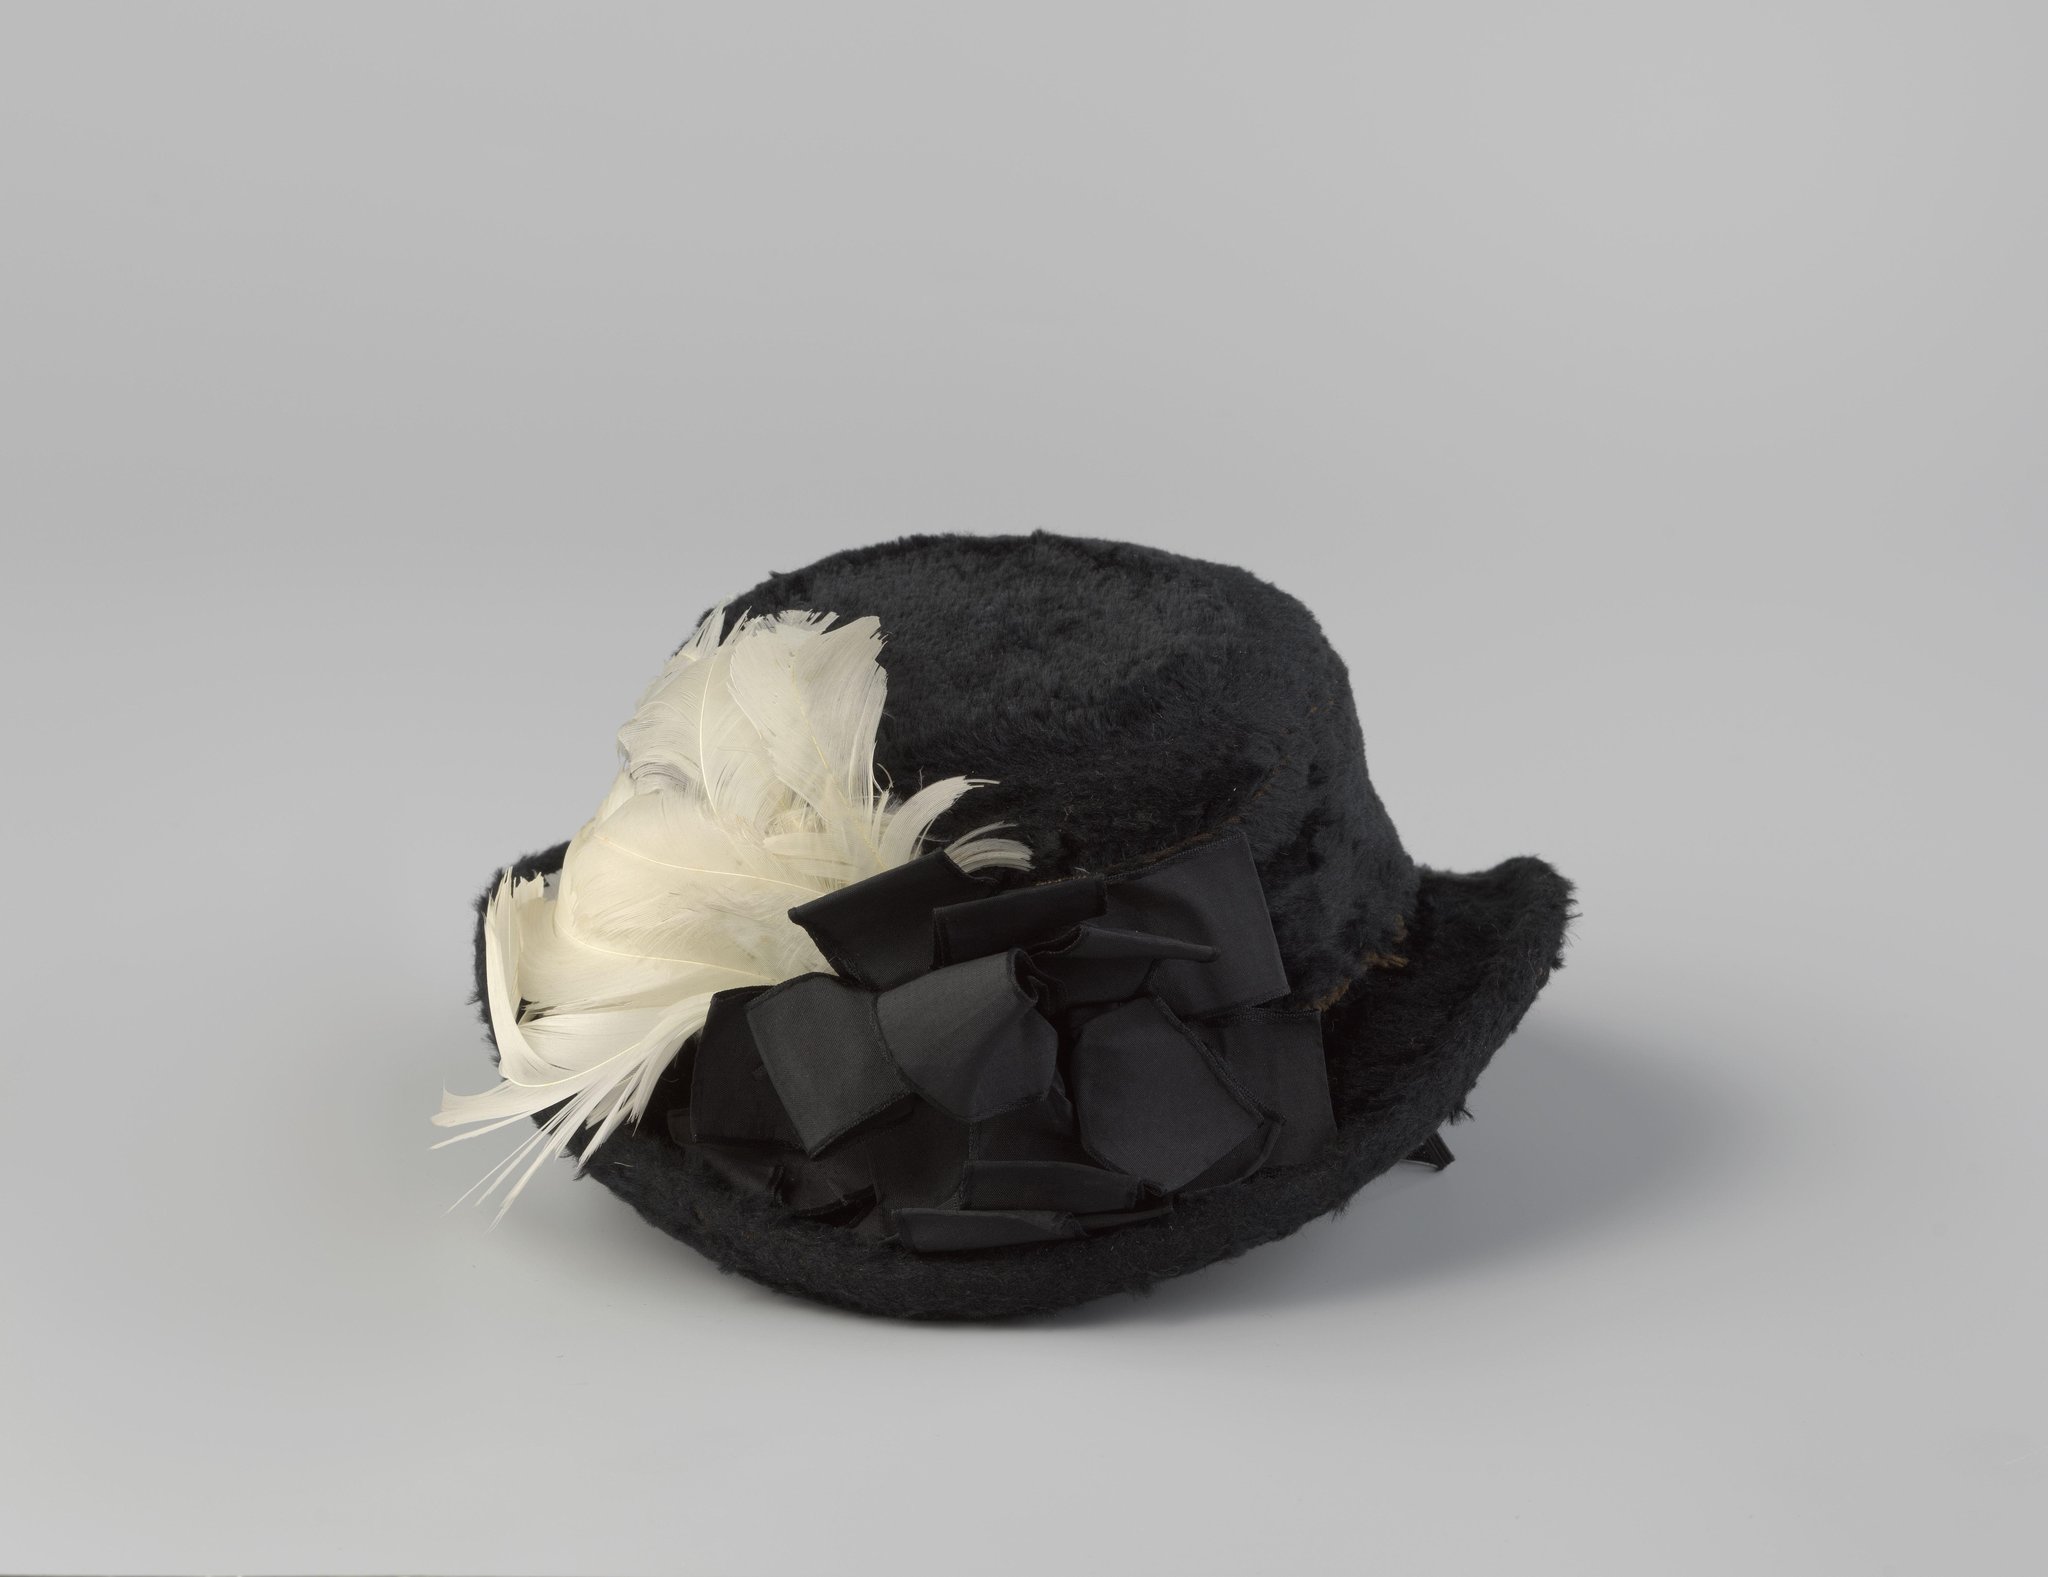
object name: doll's clothing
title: Hoed, winterhoed, van zwart vilt met ongelijke randen, witte veren en zwarte strik in de vorm van een bloem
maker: Anonymous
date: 1850-1910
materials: felt, silk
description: Hoed, winterhoed, van zwart vilt, gevoerd met zwarte zijde. Model: vrij lage bol met ongelijke rand. Versiering met witte veren en een strik in de vorm van een bloem.